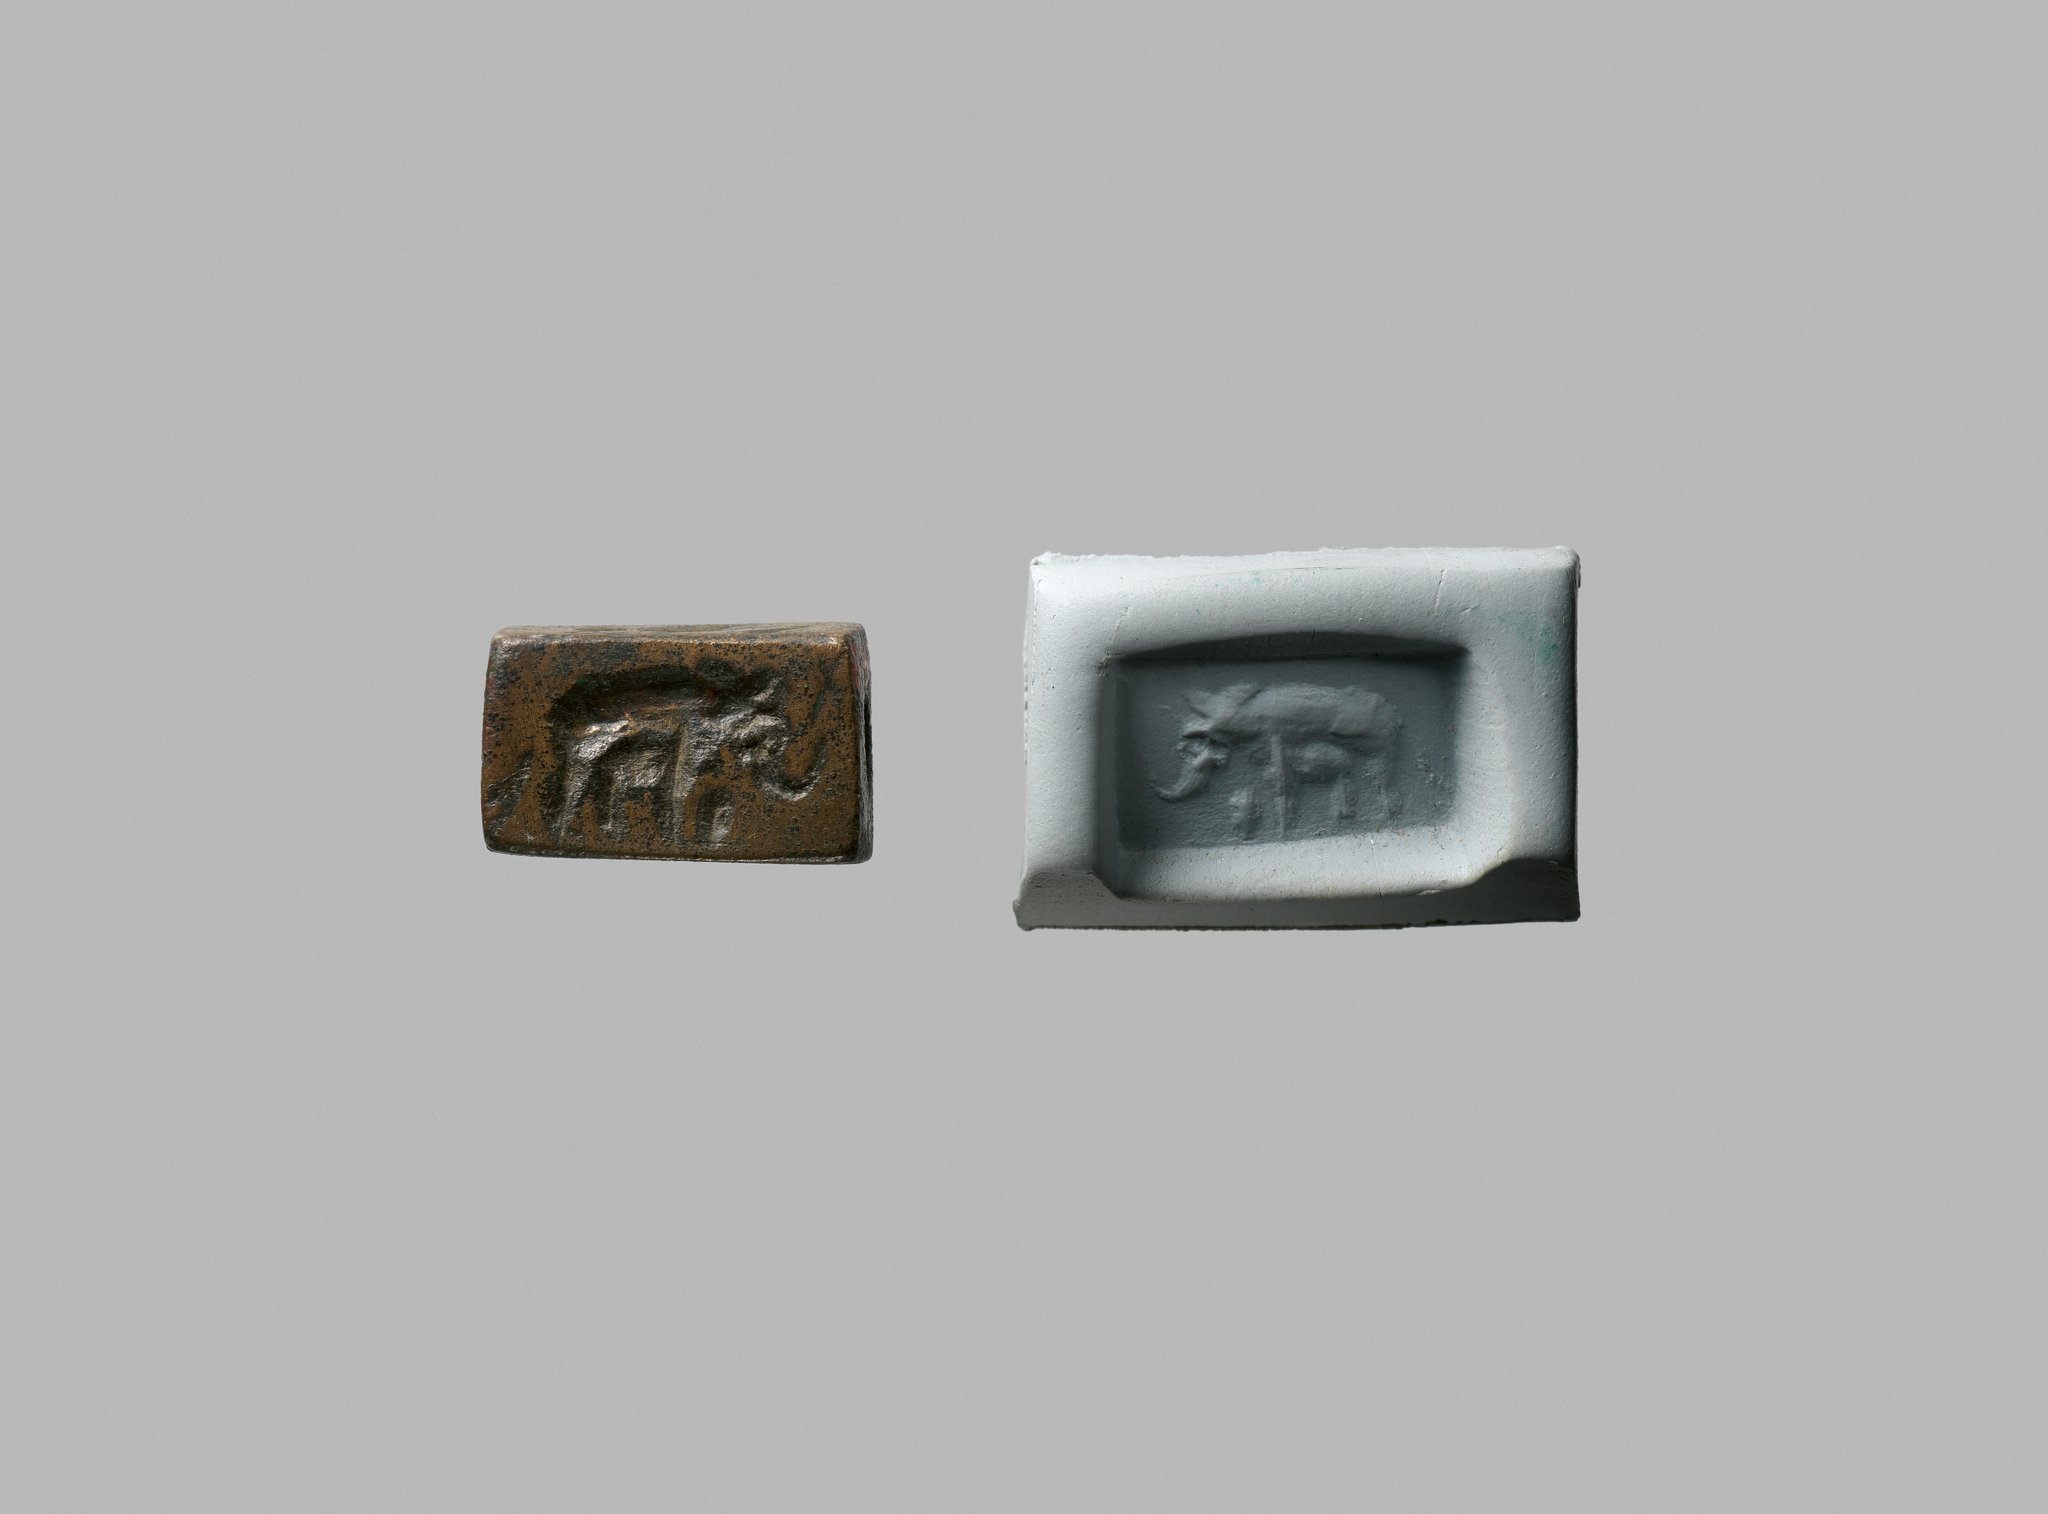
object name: stamp seal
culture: gandhara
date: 201-400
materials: bronze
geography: indus region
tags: elephants